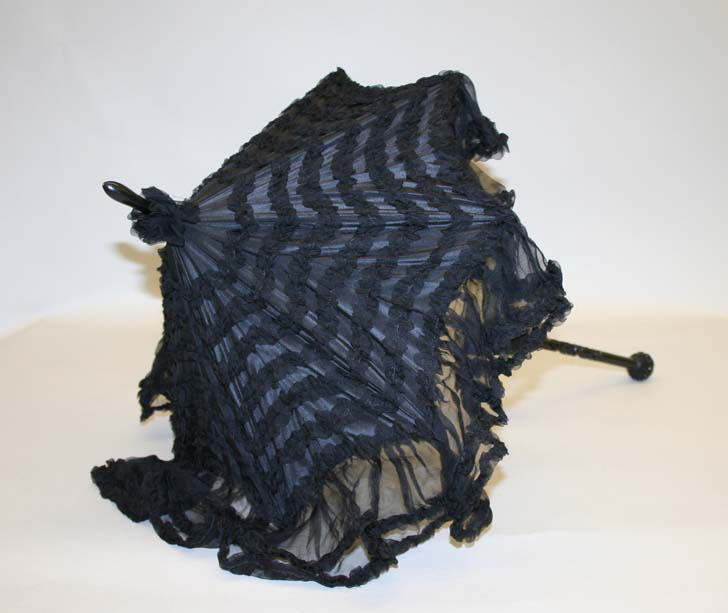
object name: parasol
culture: american or european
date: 1850-1900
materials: silk, wood